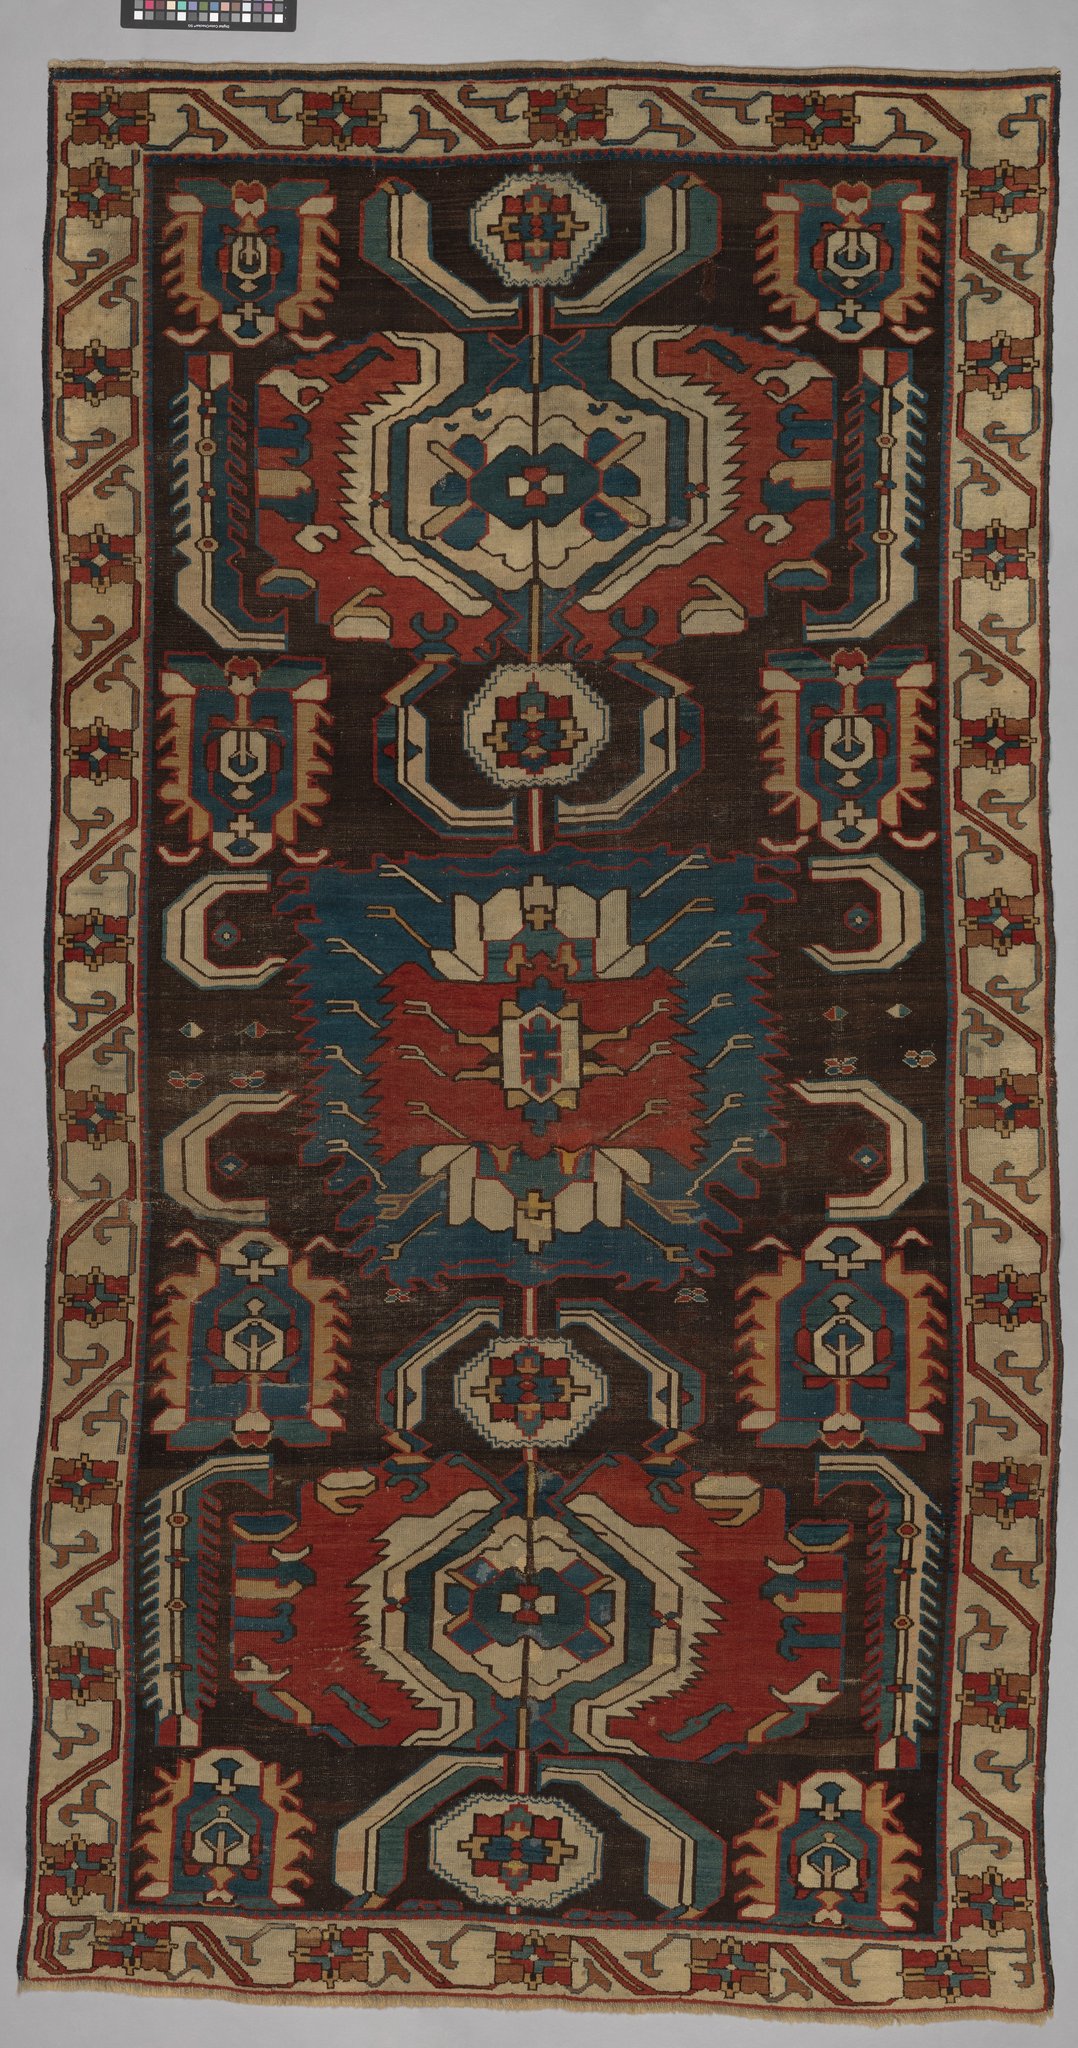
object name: carpet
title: Carpet with a Geometricized Medallion Design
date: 1701-1800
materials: wool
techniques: pile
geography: azerbaijan